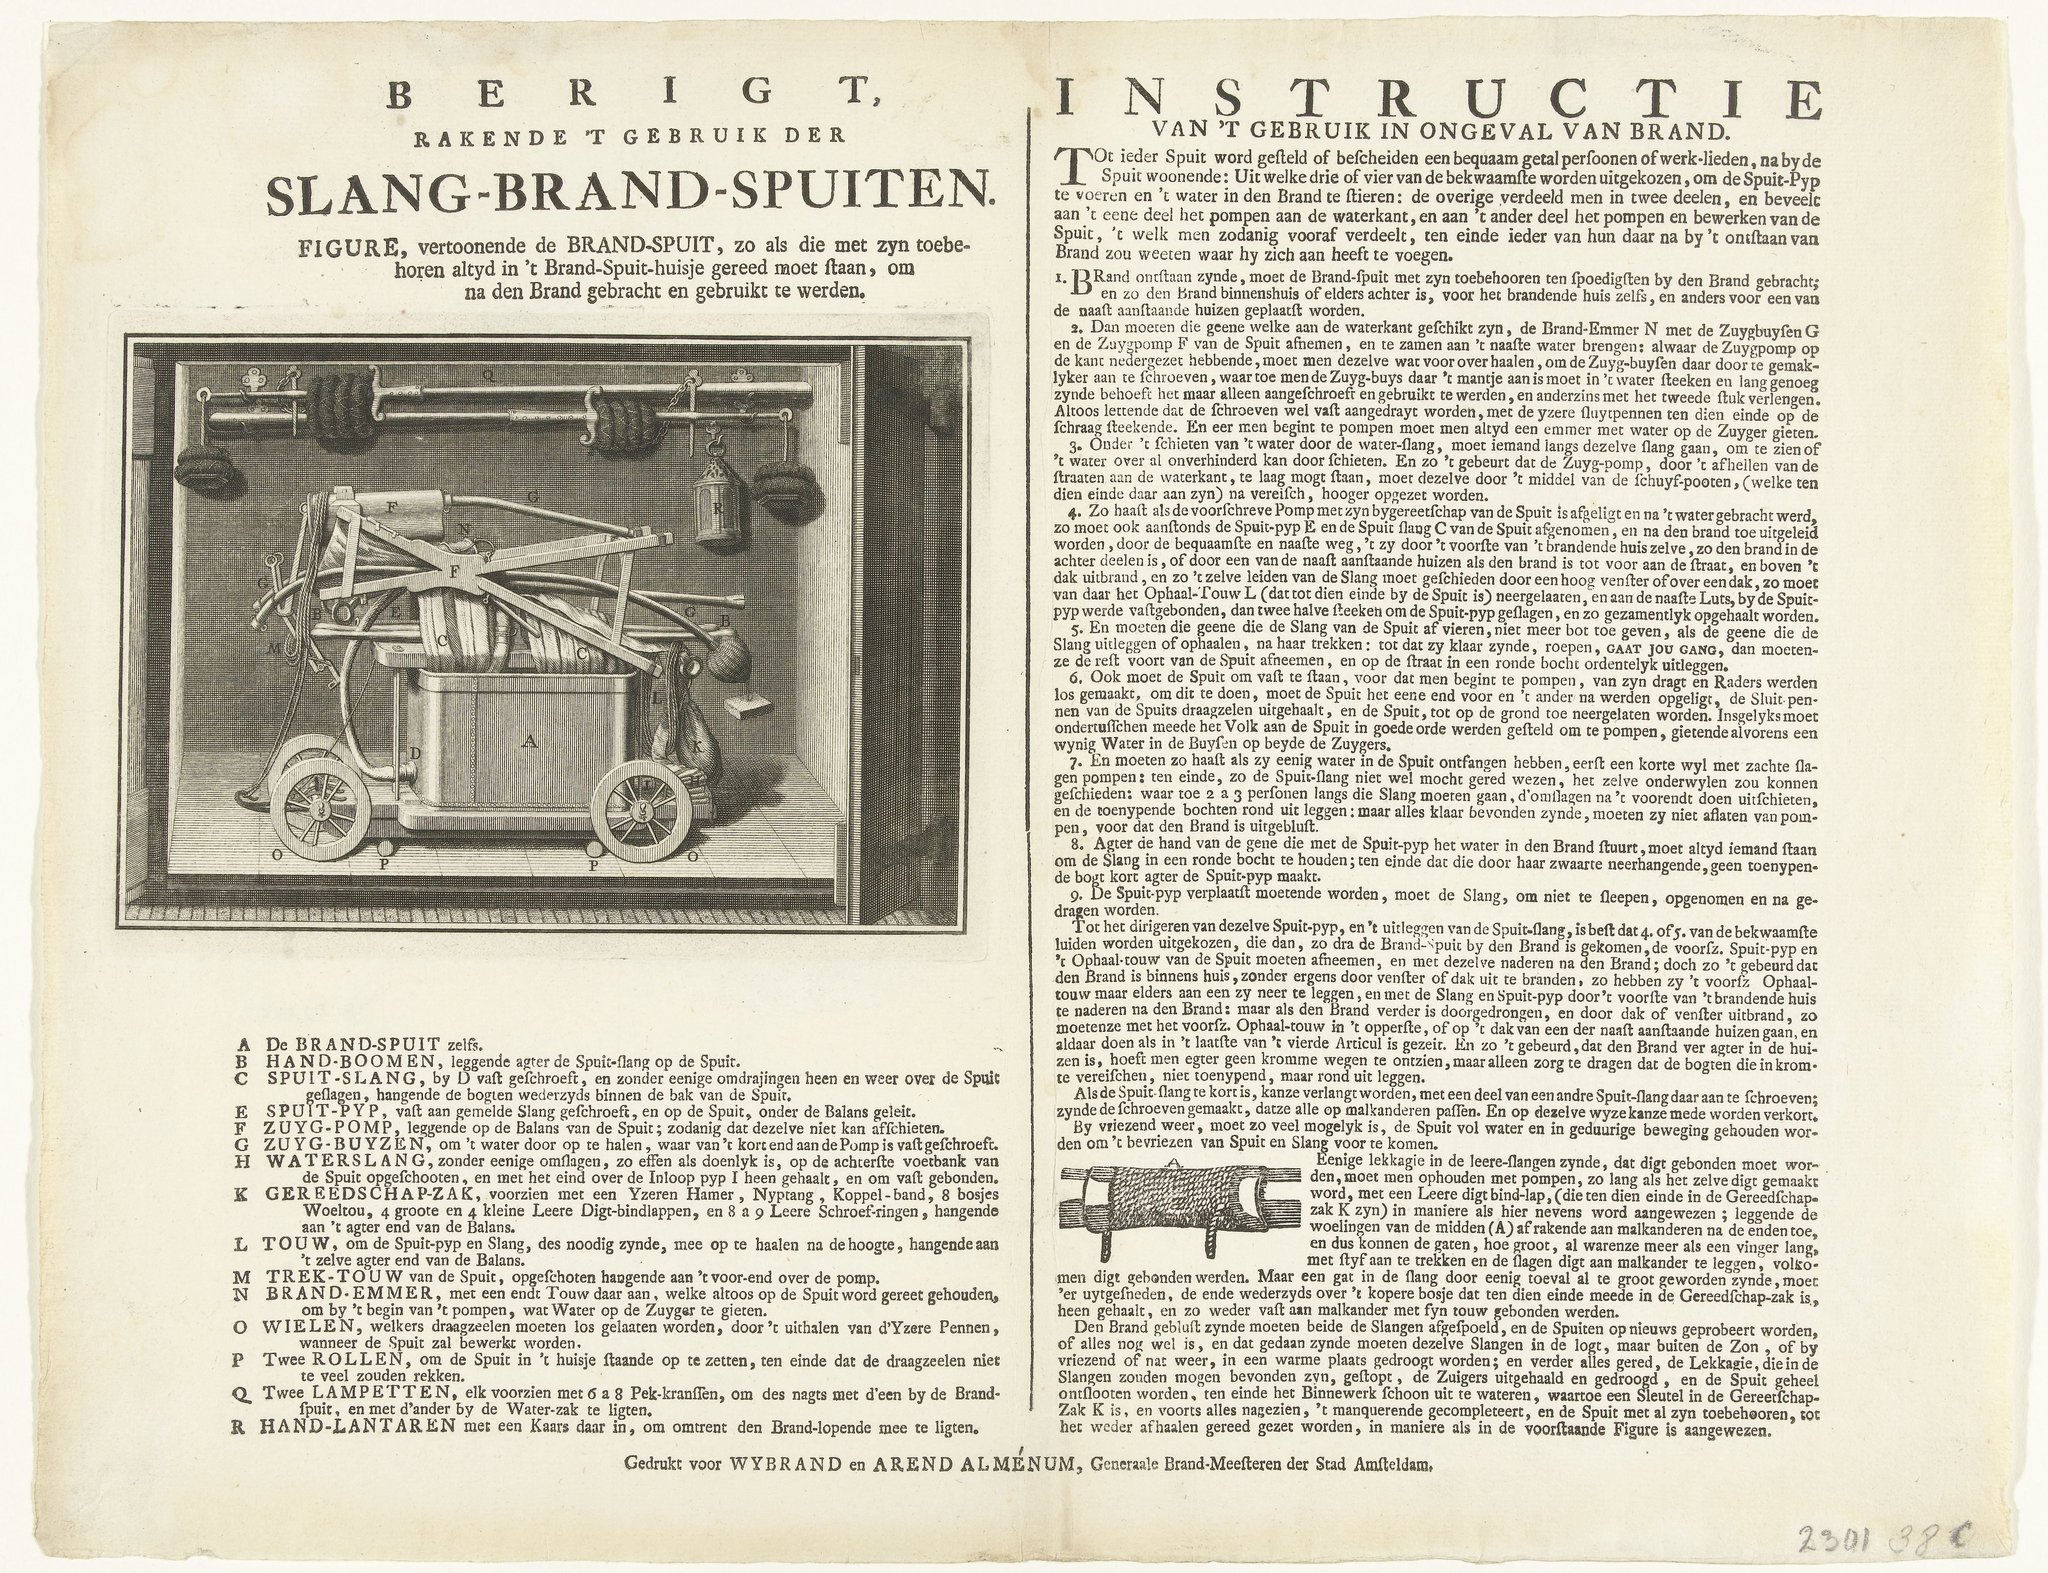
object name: print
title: Instructie over het gebruik van de slangbrandspuiten, ca. 1765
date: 1760-1768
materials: paper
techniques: etching, letterpress printing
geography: northern netherlands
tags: amsterdam, painter, draughtsman, jan van der heyden, fire-extinguishing equipment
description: Blad met een instructie over het correcte gebruik en bewaring van de slangbrandspuiten, ca. 1765. Links een voorstelling hoe de slangbrandspuit en pomp in het brandspuithuisje opgeborgen dienen te worden na gebruik, met de legenda A-R. Rechts de instructie voor gebruik in het geval van brand genummerd 1-9 en een plaatje hoe een lekkage in een slang gerepareerd dient te worden. Behoort tot de bijprenten bij het Brandspuitenboek van Jan van der Heyden.